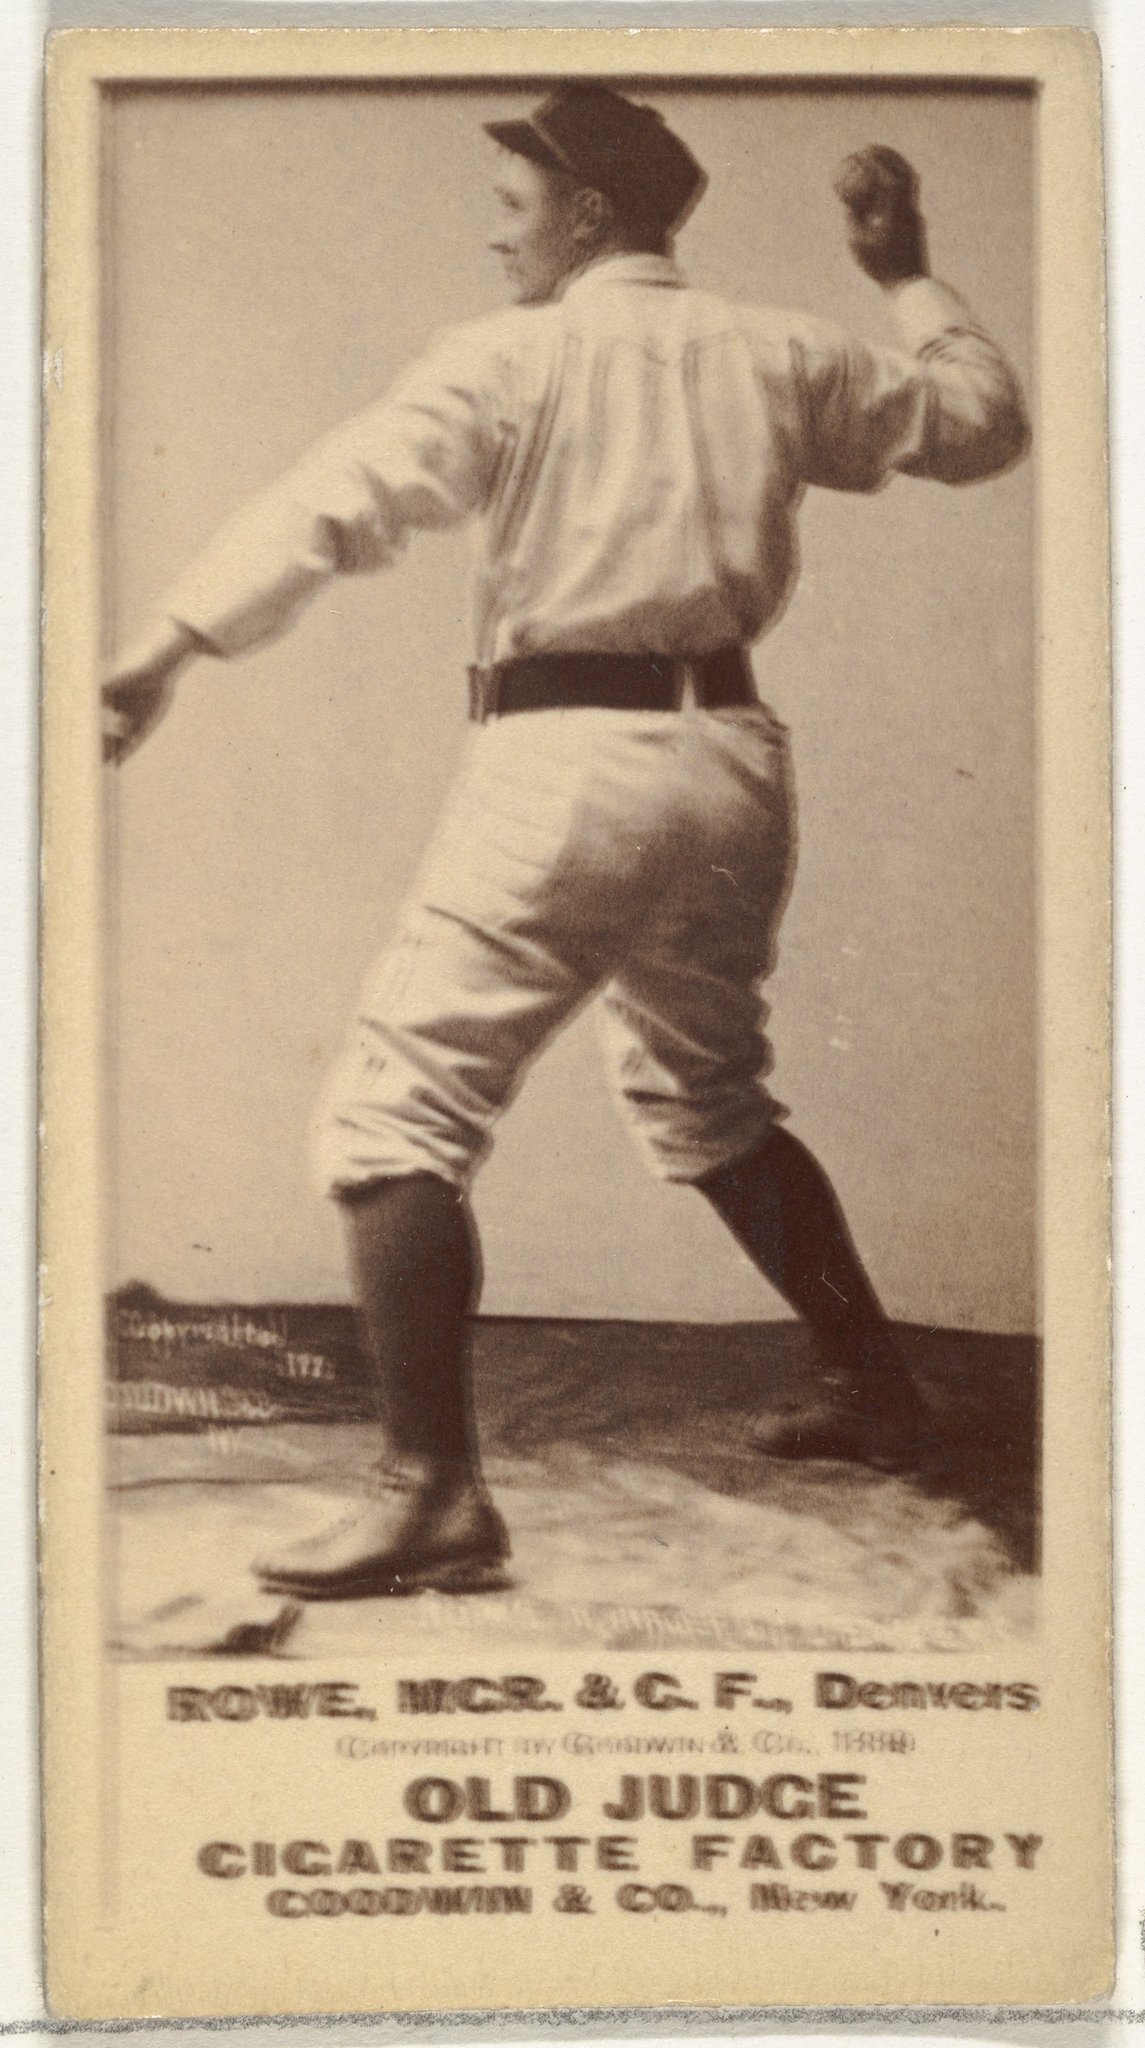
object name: baseball card, photograph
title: David Elwood "Dave" Rowe, Manager and Center Field, Denver, from the Old Judge series (N172) for Old Judge Cigarettes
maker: goodwin & company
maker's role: publisher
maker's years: 1850-1950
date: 1889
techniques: albumen silver print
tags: men,portraits,baseball,athletes